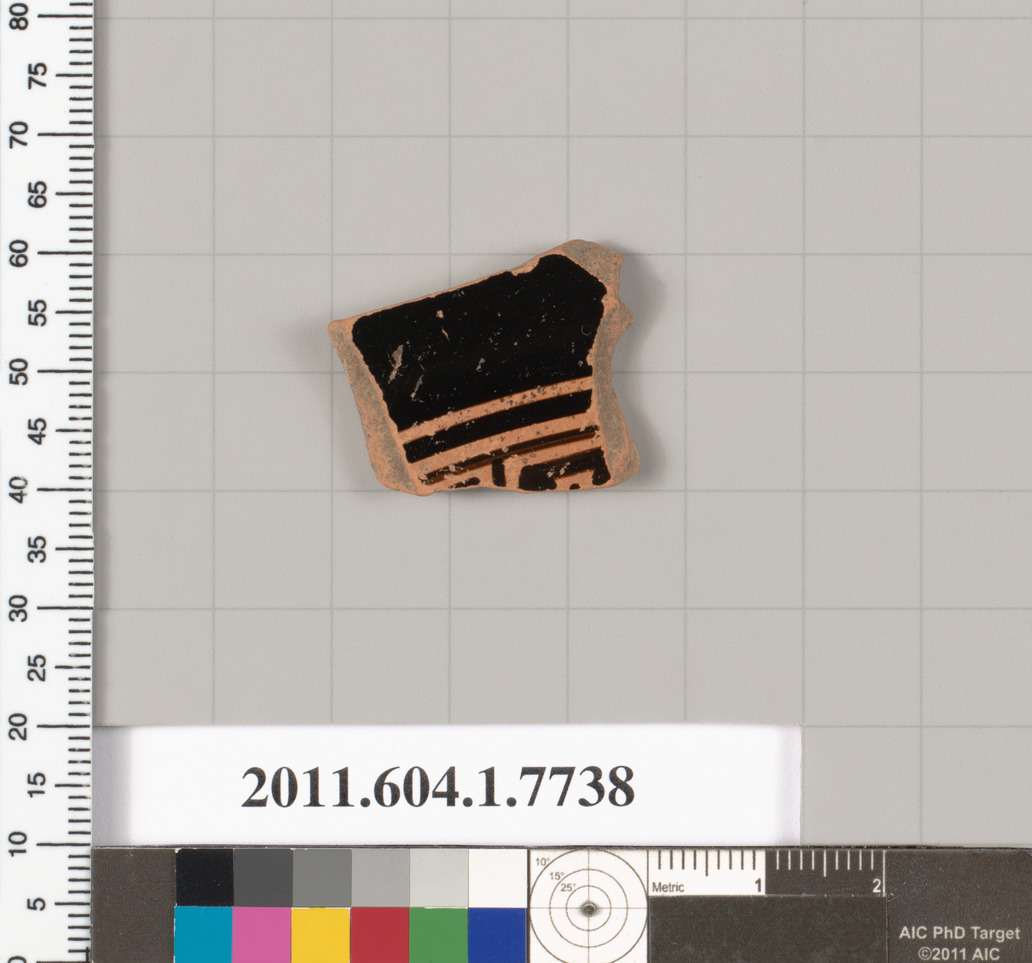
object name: kylix fragment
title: Terracotta fragment of a kylix (drinking cup)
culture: greek, attic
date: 460-450 BCE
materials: terracotta